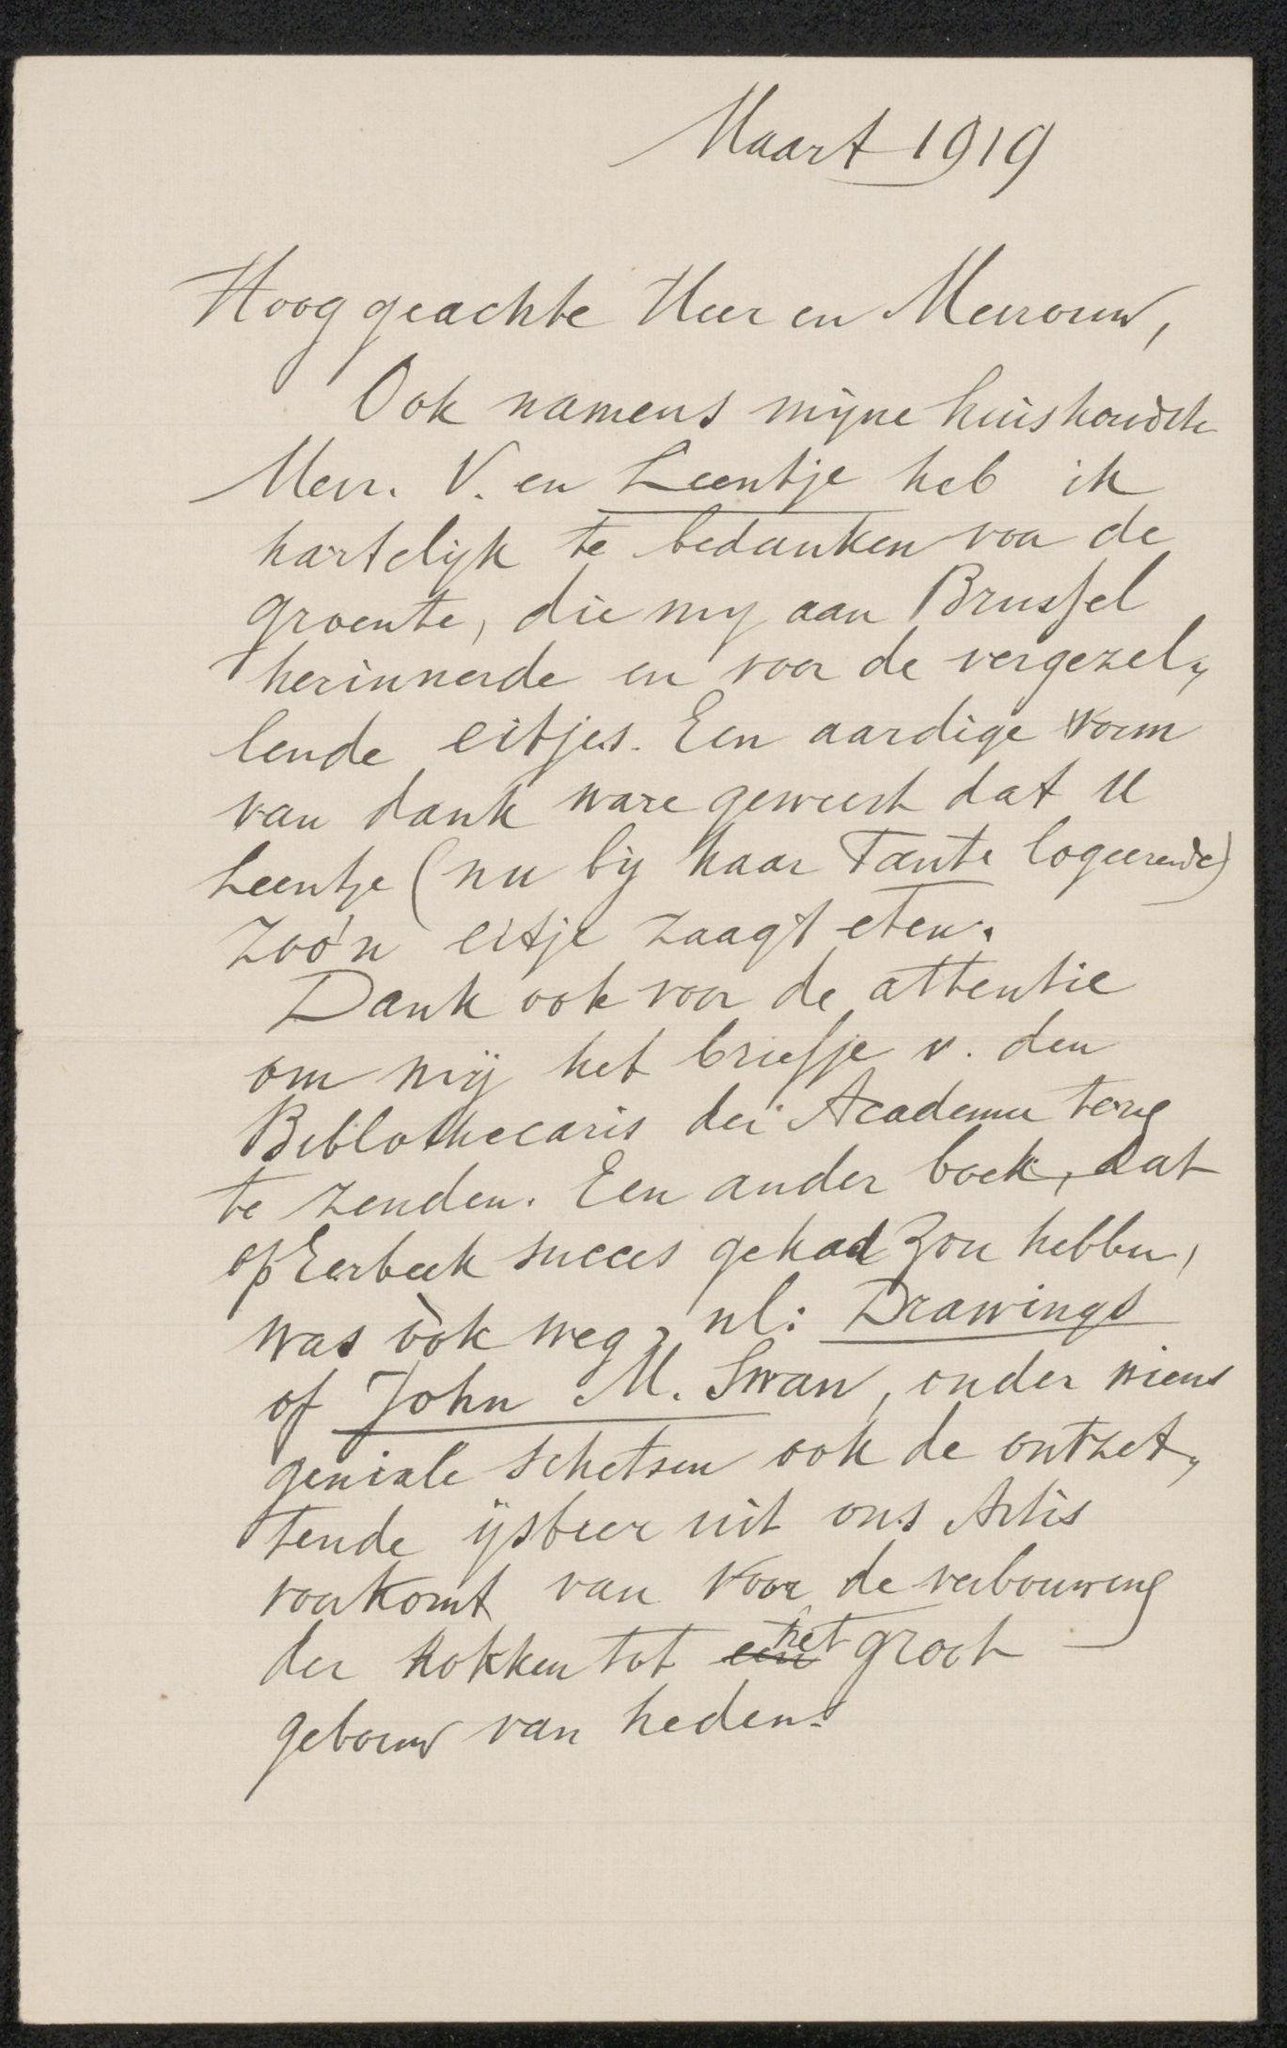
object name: letter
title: Brief aan Max Wilhelm Carl Weber en Anne Antoinette Weber-Van Bosse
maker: august allebé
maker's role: draughtsman, print maker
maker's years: 1838-1927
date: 1903-1919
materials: ink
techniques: pen, writing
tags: painter, draughtsman, john macallan swan, amsterdam, anne antoinette weber-van bosse